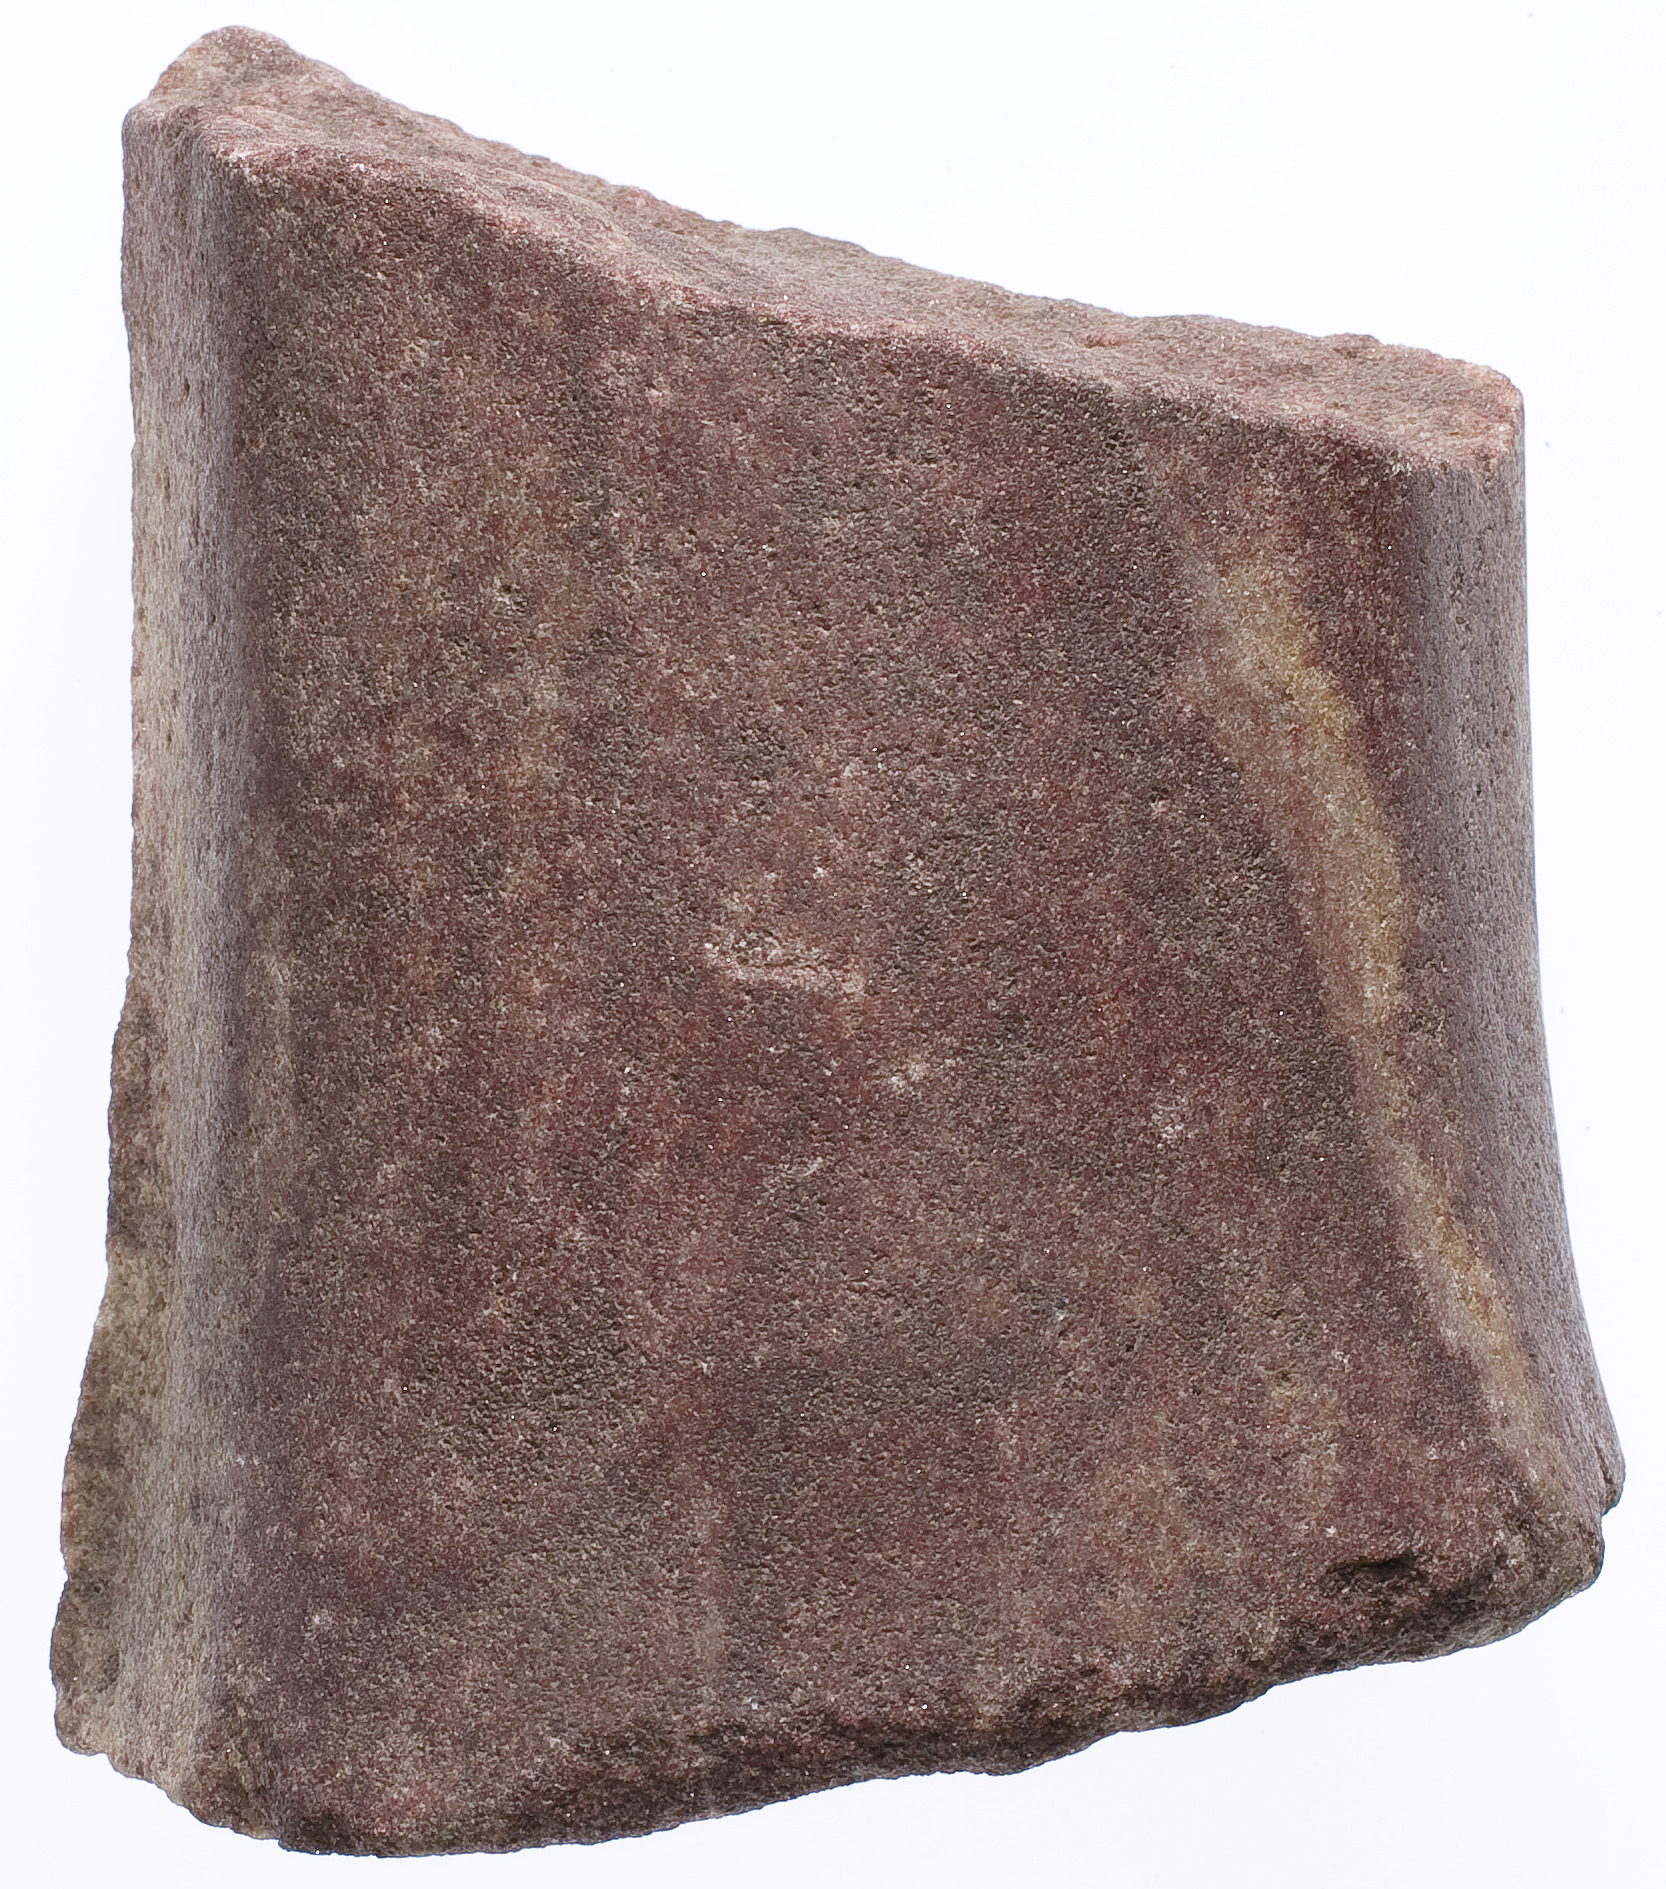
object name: limb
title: Limb fragment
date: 1353-1336 BCE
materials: quartzite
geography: egypt